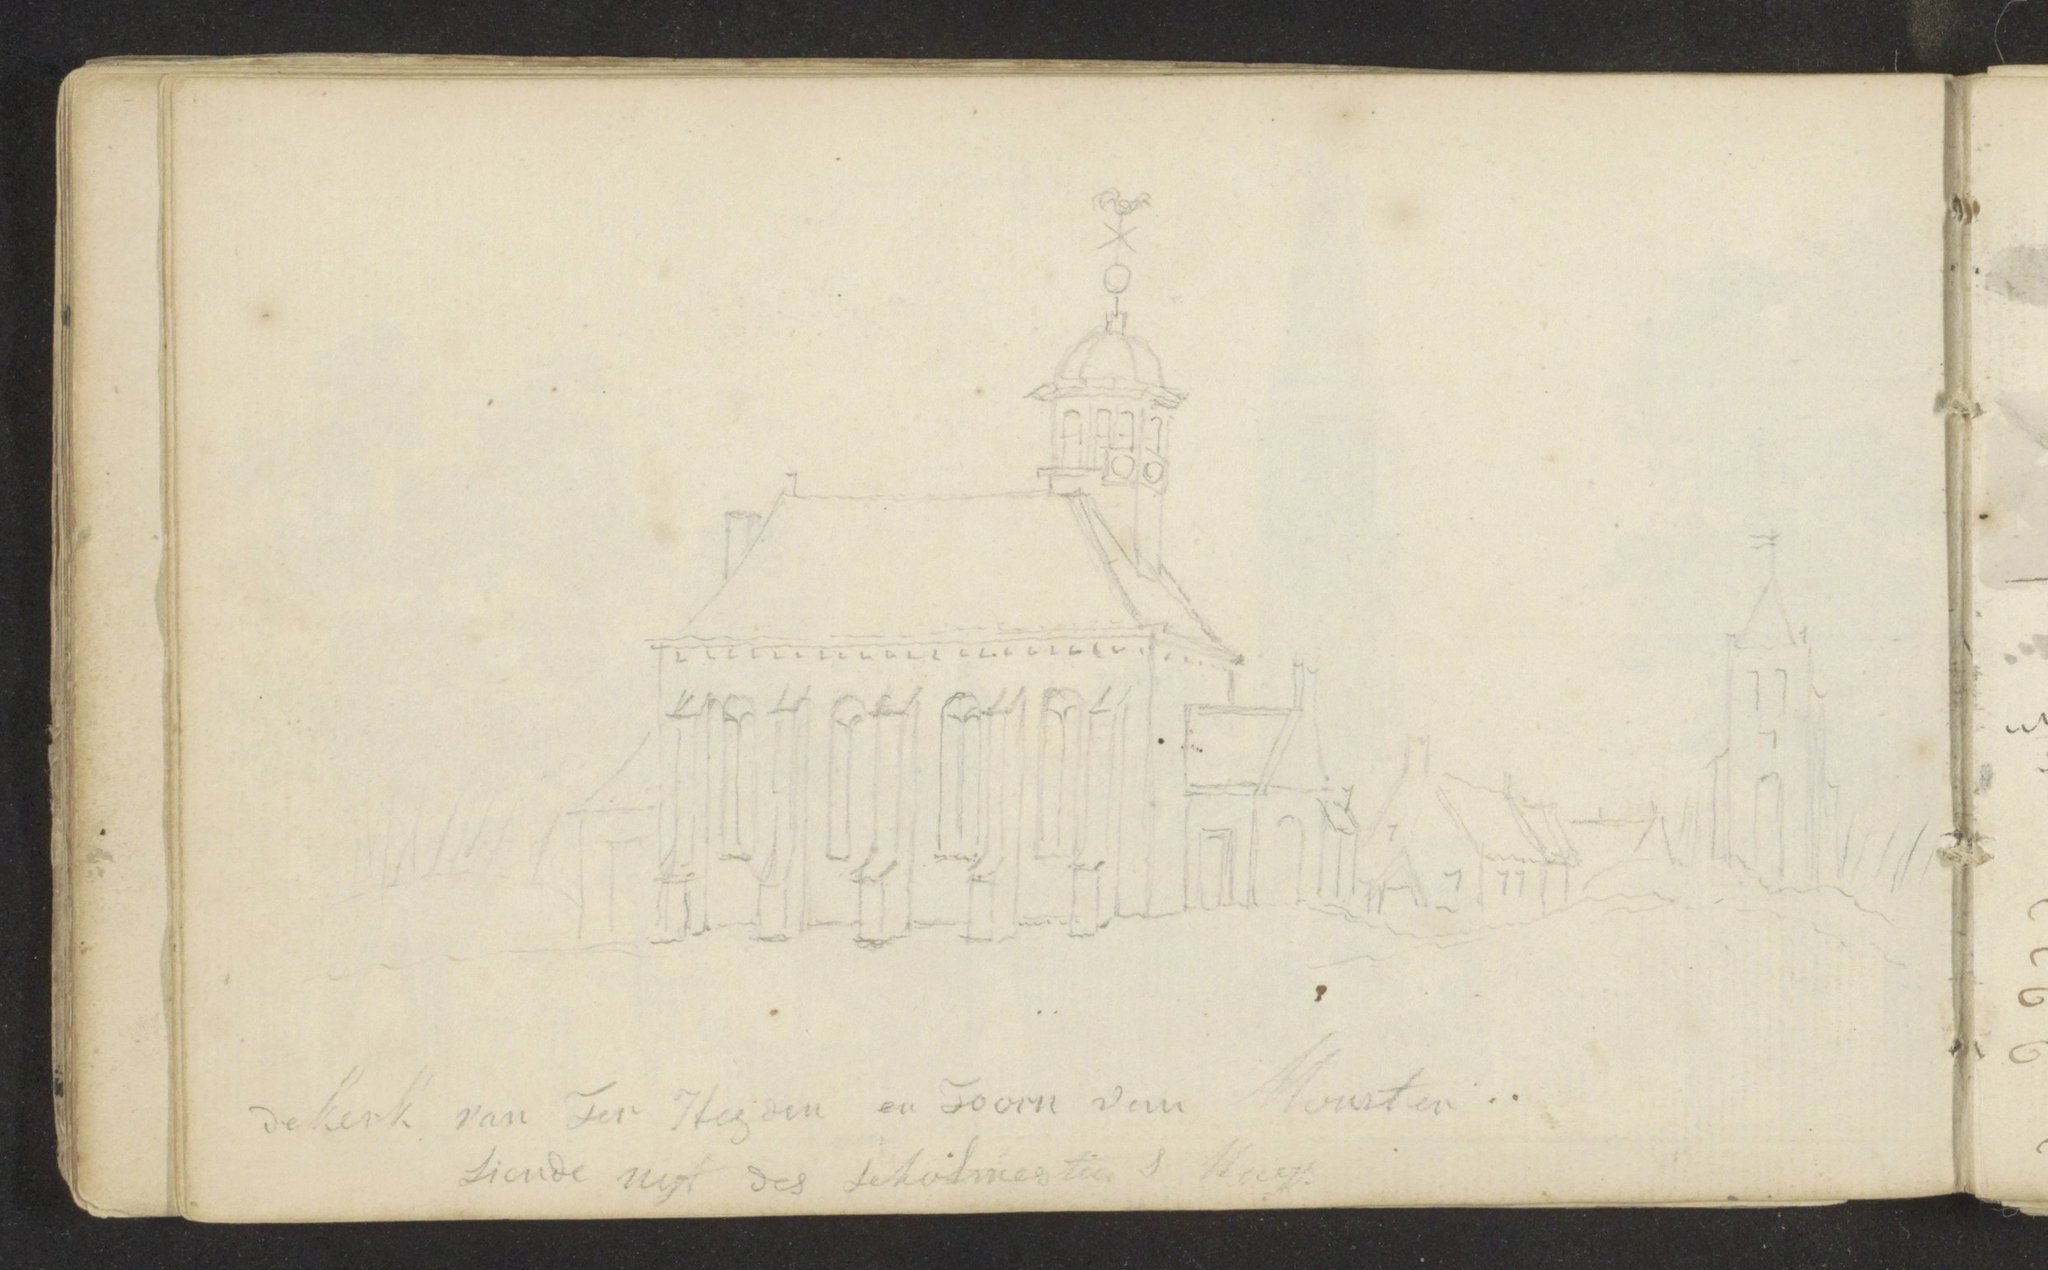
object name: sketchbook leaf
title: Kerk te Ter Heijde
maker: abraham de haen (ii)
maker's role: draughtsman, print maker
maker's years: 1707-1748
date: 1731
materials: paper, pencil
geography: ter heijde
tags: church (exterior)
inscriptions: annotation: ‘de kerk van Ter Heijden en Toorn van Houten/ ...’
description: Blad 12 verso uit een schetsboek met 78 bladen.